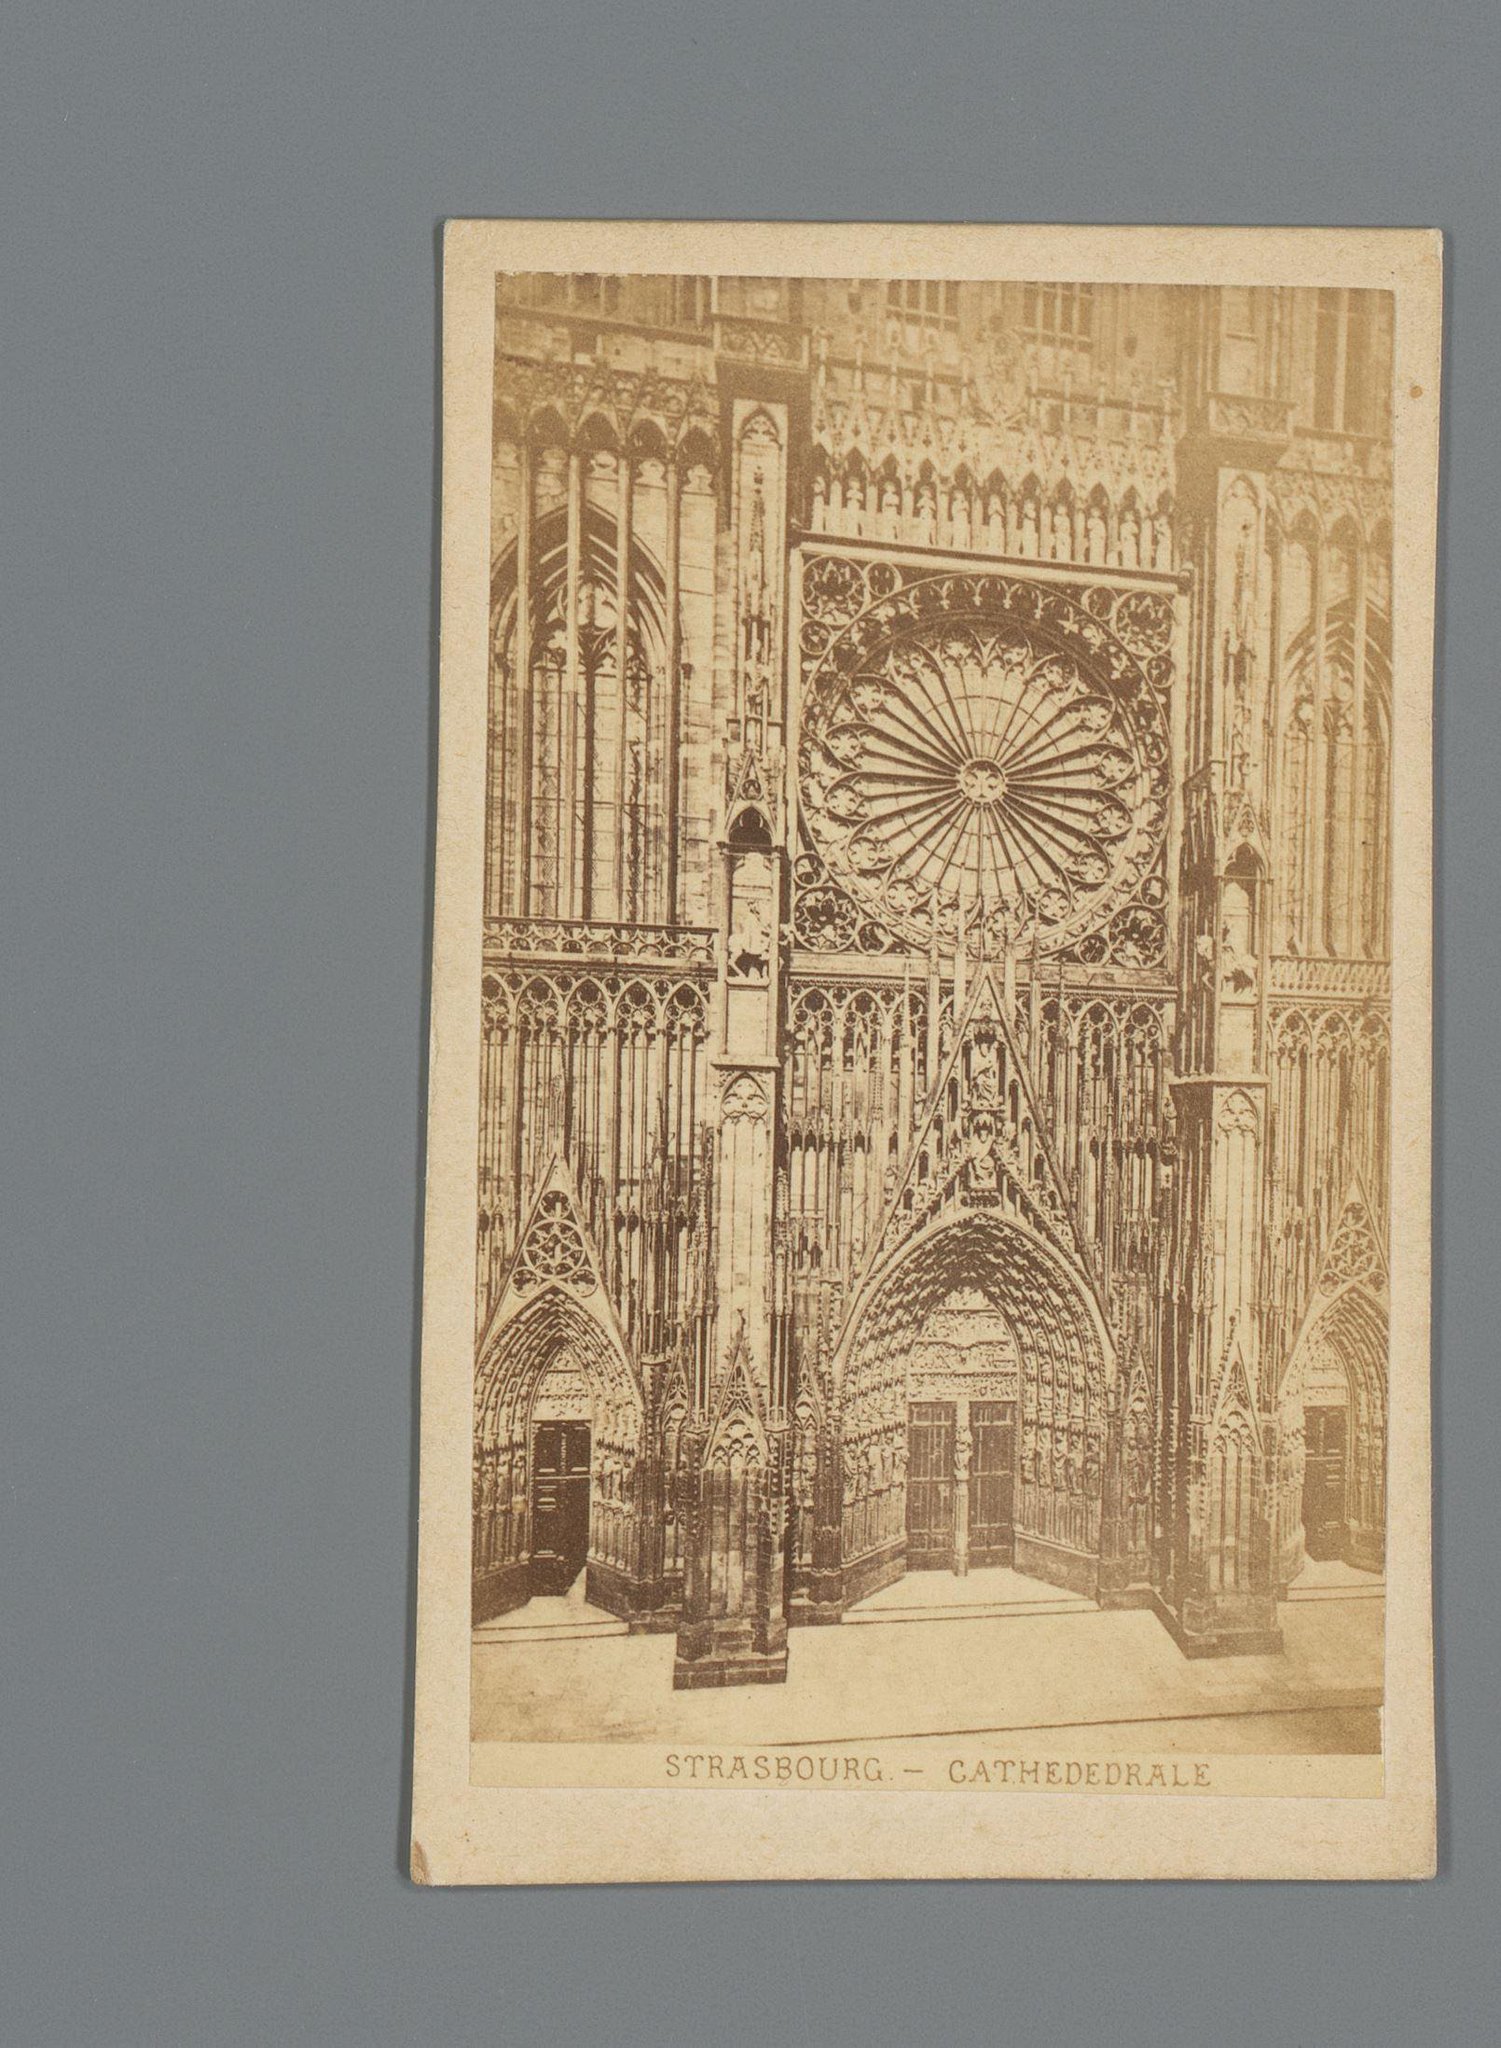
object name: carte de visite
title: Strasbourg - cathedrale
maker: Anonymous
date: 1854-1885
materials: cardboard, paper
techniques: albumen print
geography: straatsburg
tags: parts of church exterior and annexes: west façade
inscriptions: inscription: ‘€1’